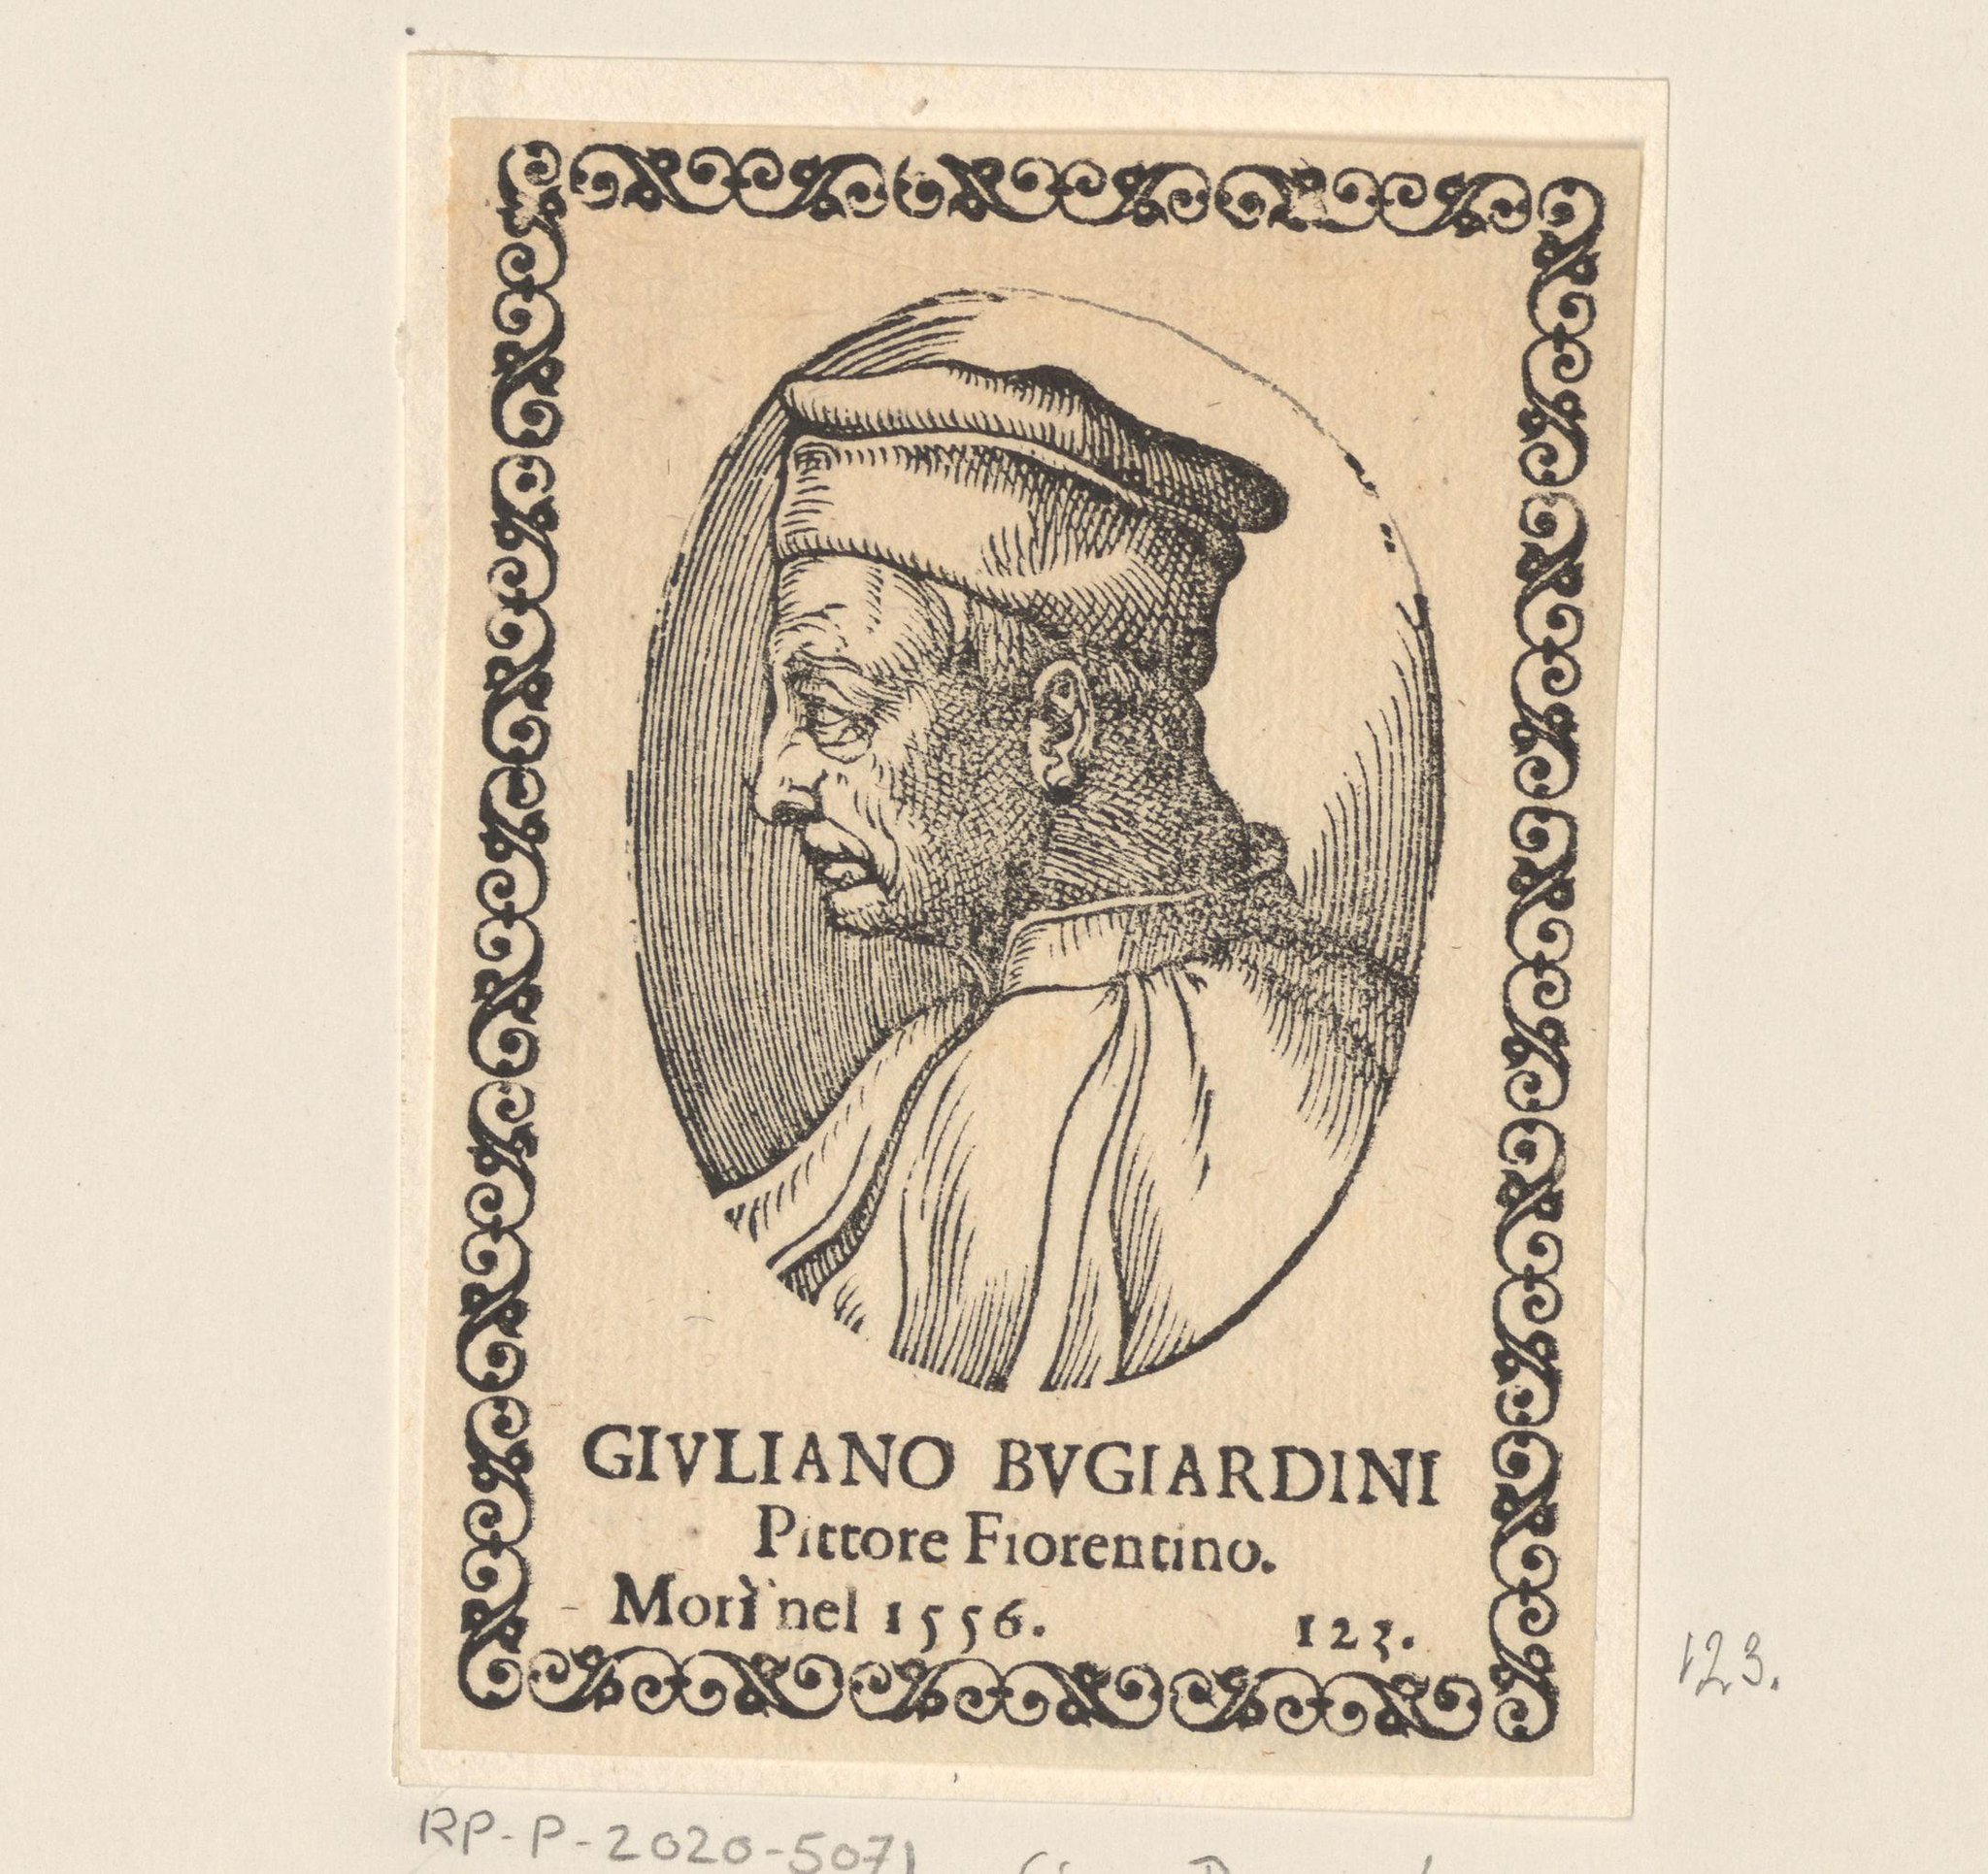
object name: print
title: Portret van Giuliano Bugiardini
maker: Anonymous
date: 1600-1699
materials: paper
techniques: letterpress printing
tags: painter, giuliano bugiardini, historical persons, portrait, self-portrait of artist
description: Prent waarschijnlijk afkomstig uit een Italiaanse editie van: Vasari, Giorgio. Vite de' più eccellenti architetti, pittori, et scultori italiani (...).